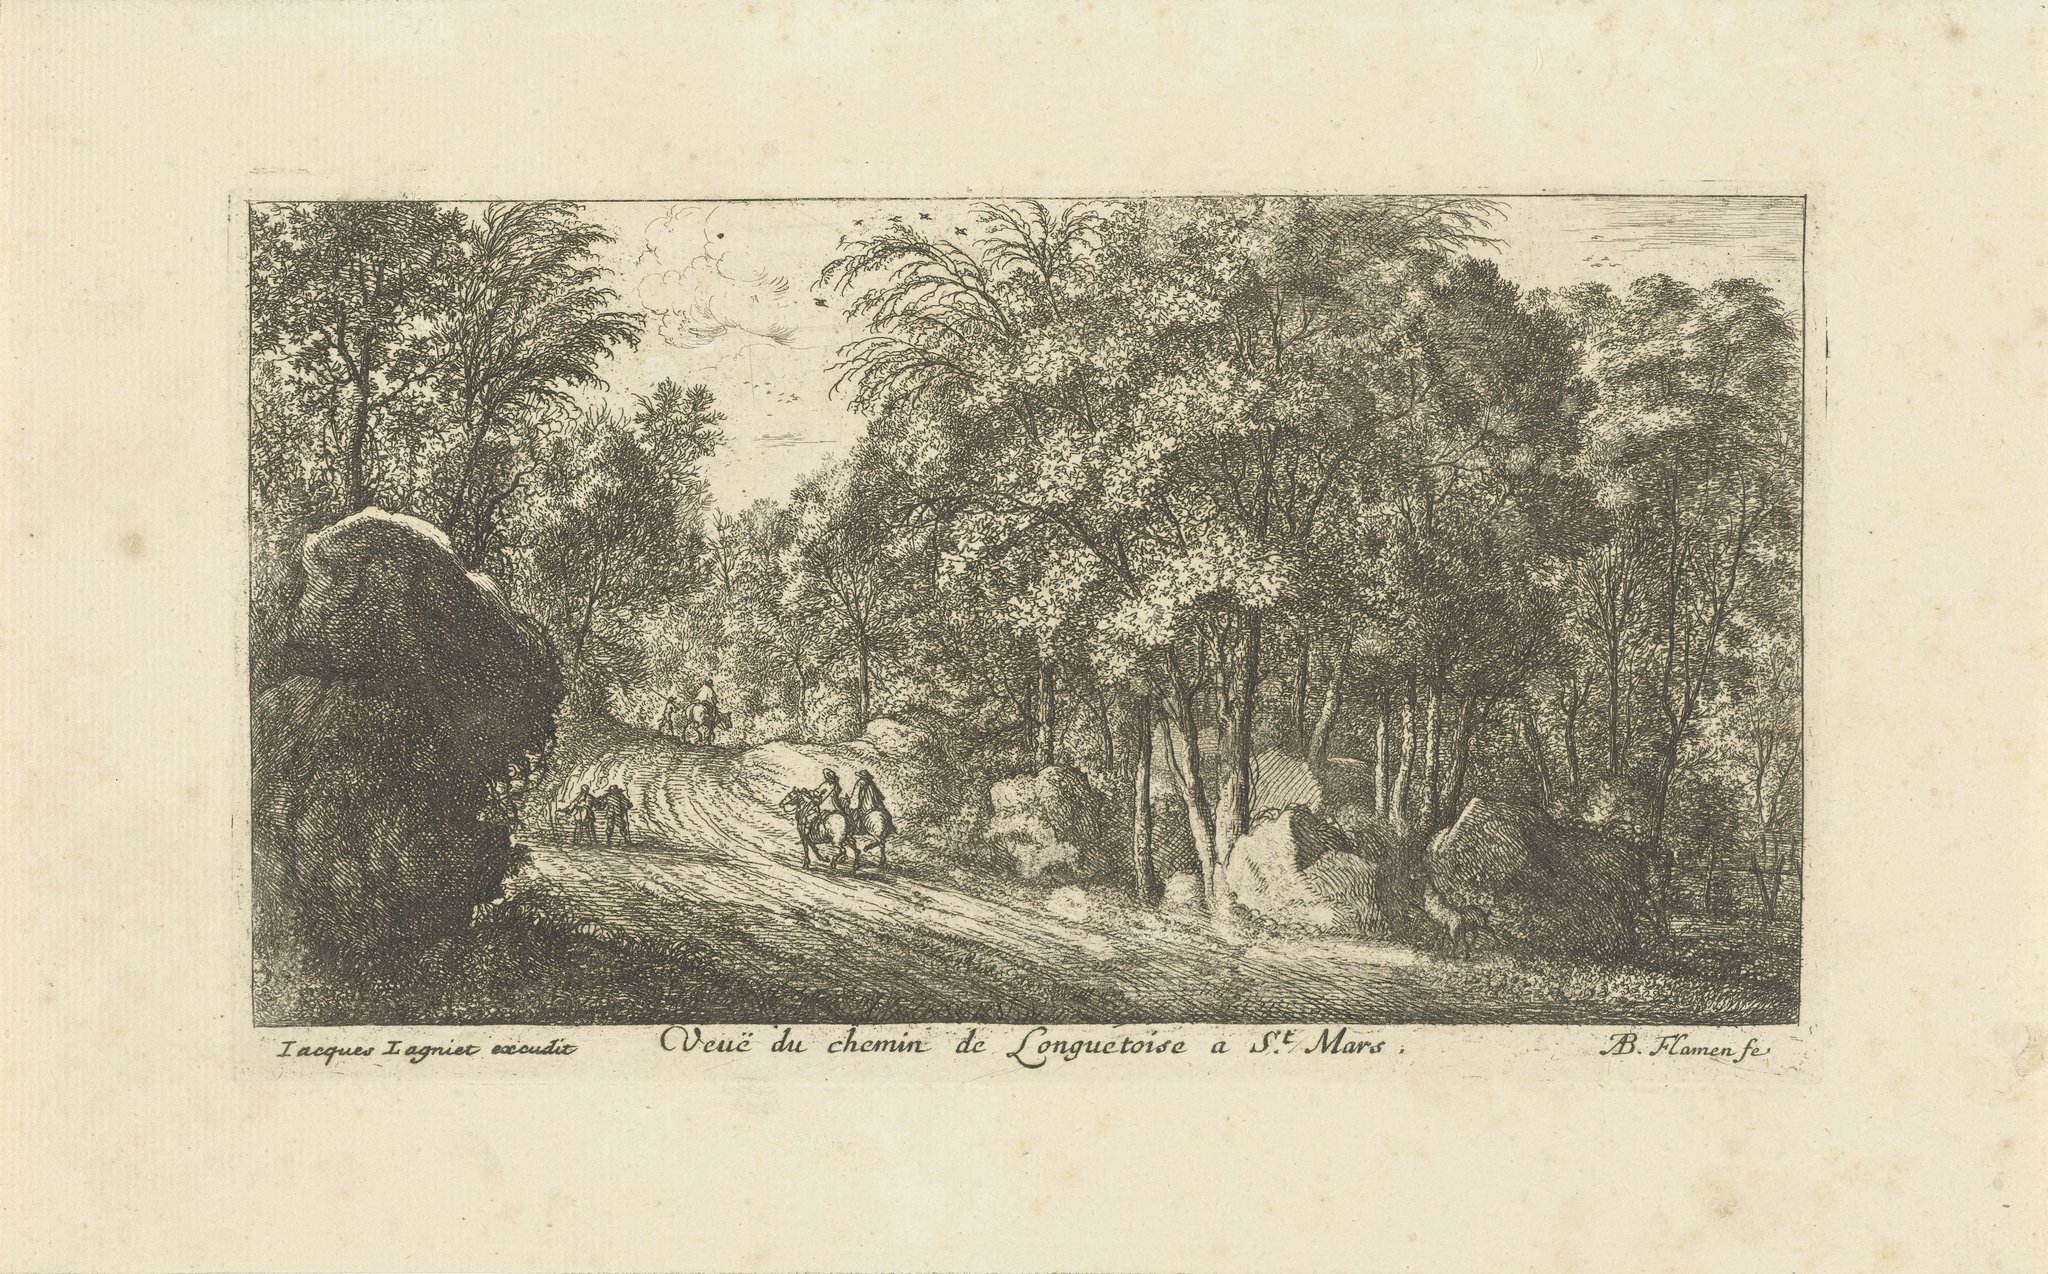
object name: print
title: Bospad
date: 1648-1672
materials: paper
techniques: etching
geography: paris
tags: forest path or lane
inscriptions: collector's mark: Lugt 2228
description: Gezicht op een pad door het bos. Op de voorgrond een rotspartij en op het pad wandelaars en ruiters.